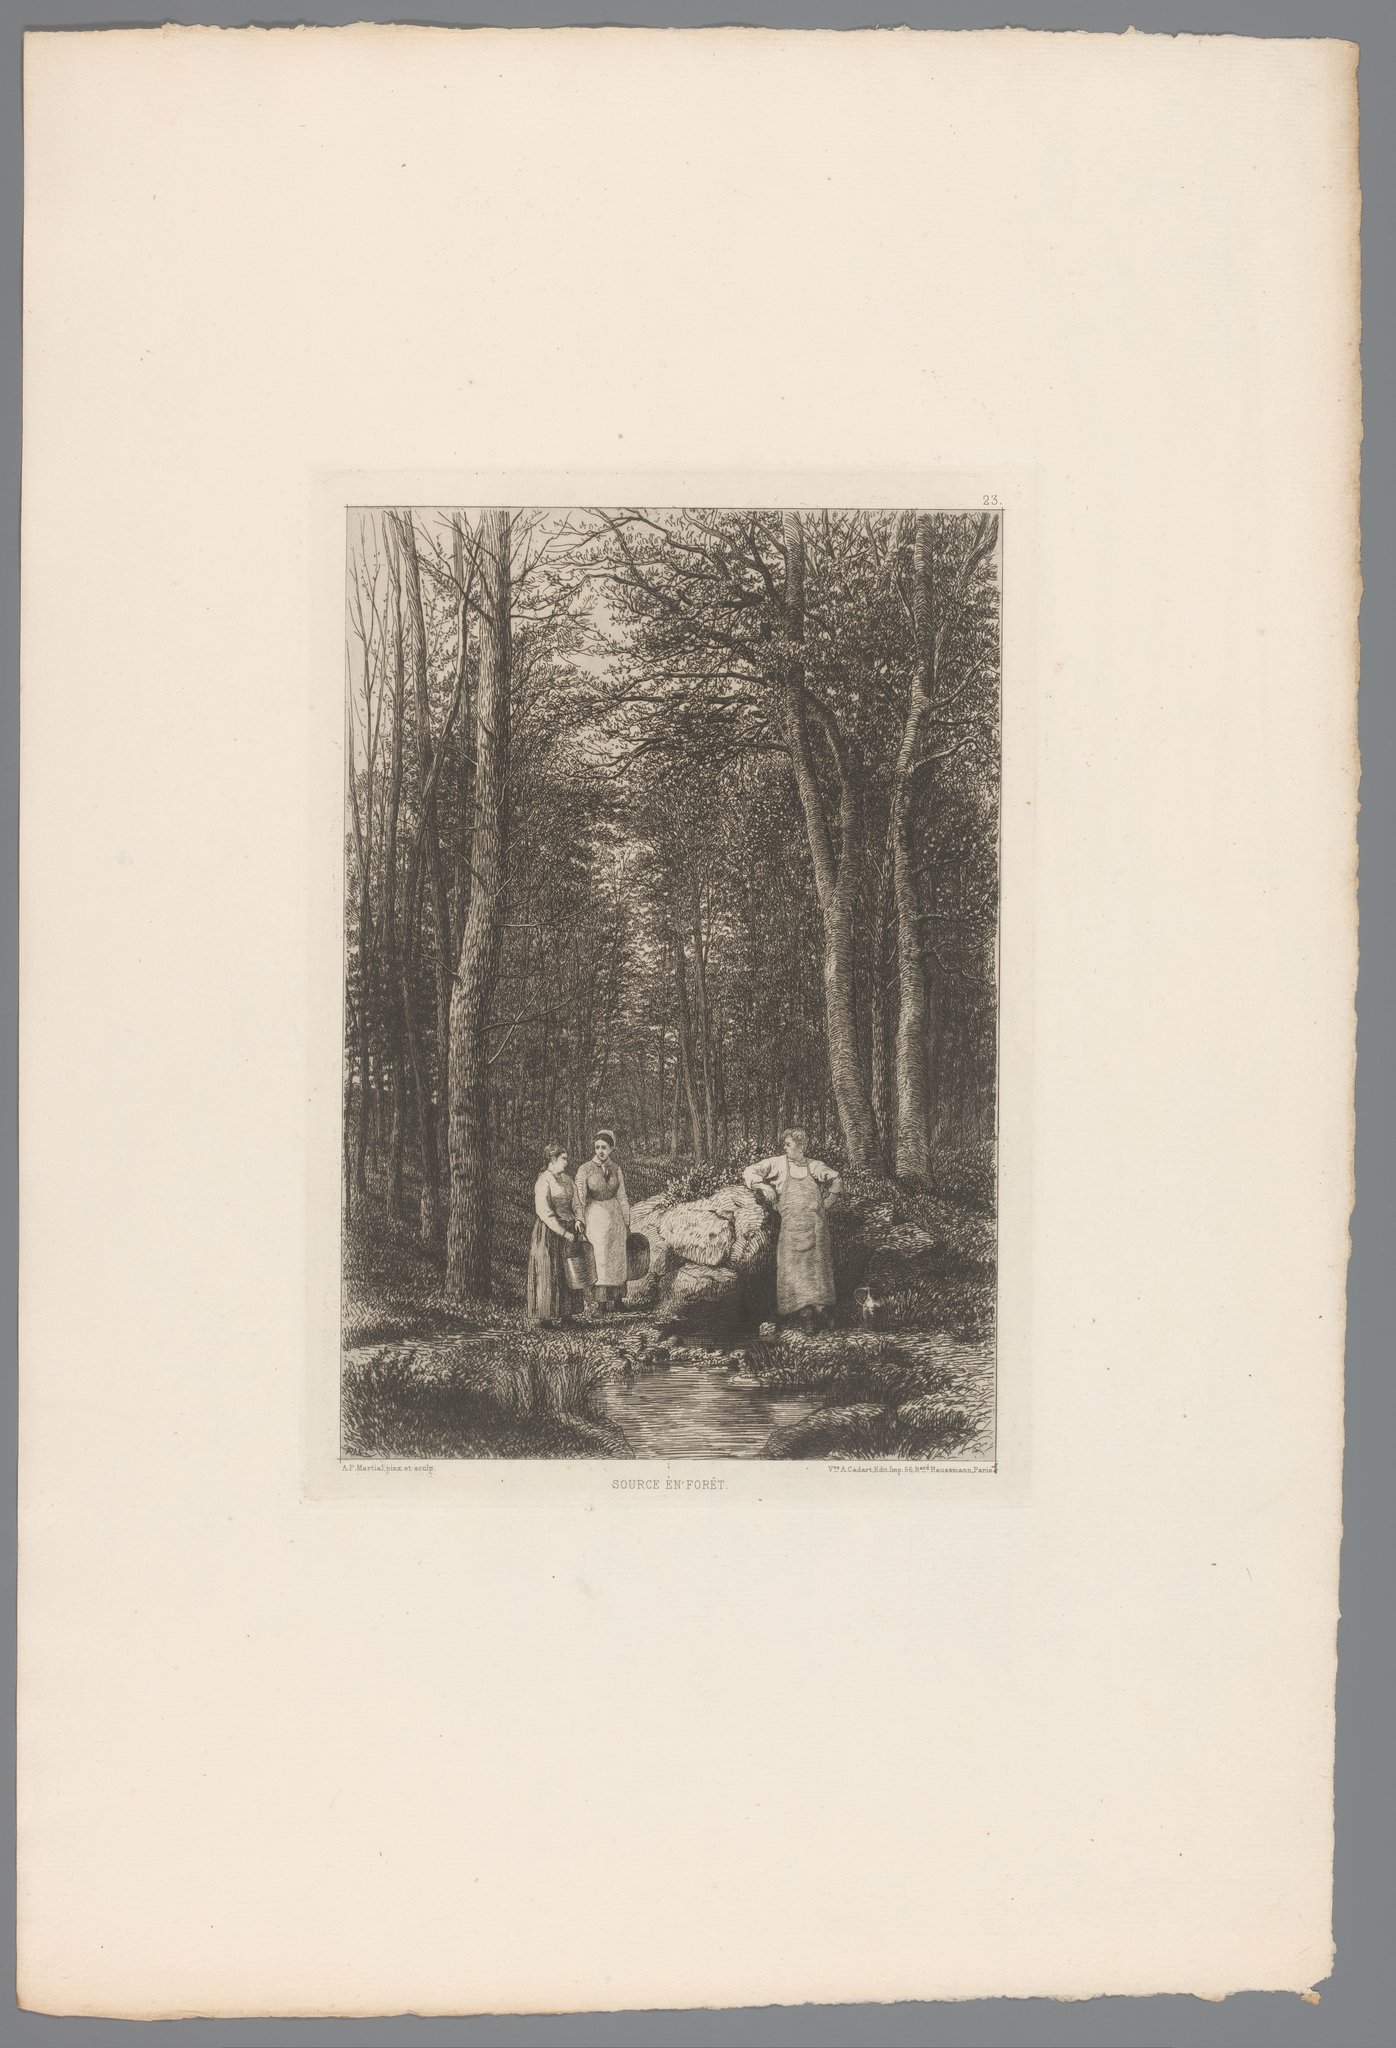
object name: print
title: L'eau-forte en 1877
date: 1877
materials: paper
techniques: drypoint, etching, intaglio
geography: paris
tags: forest, wood, spring, source of river or stream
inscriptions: collector's mark: ‘AFE v S’, collector's mark: Lugt 2228, collector's mark: Lugt 2760